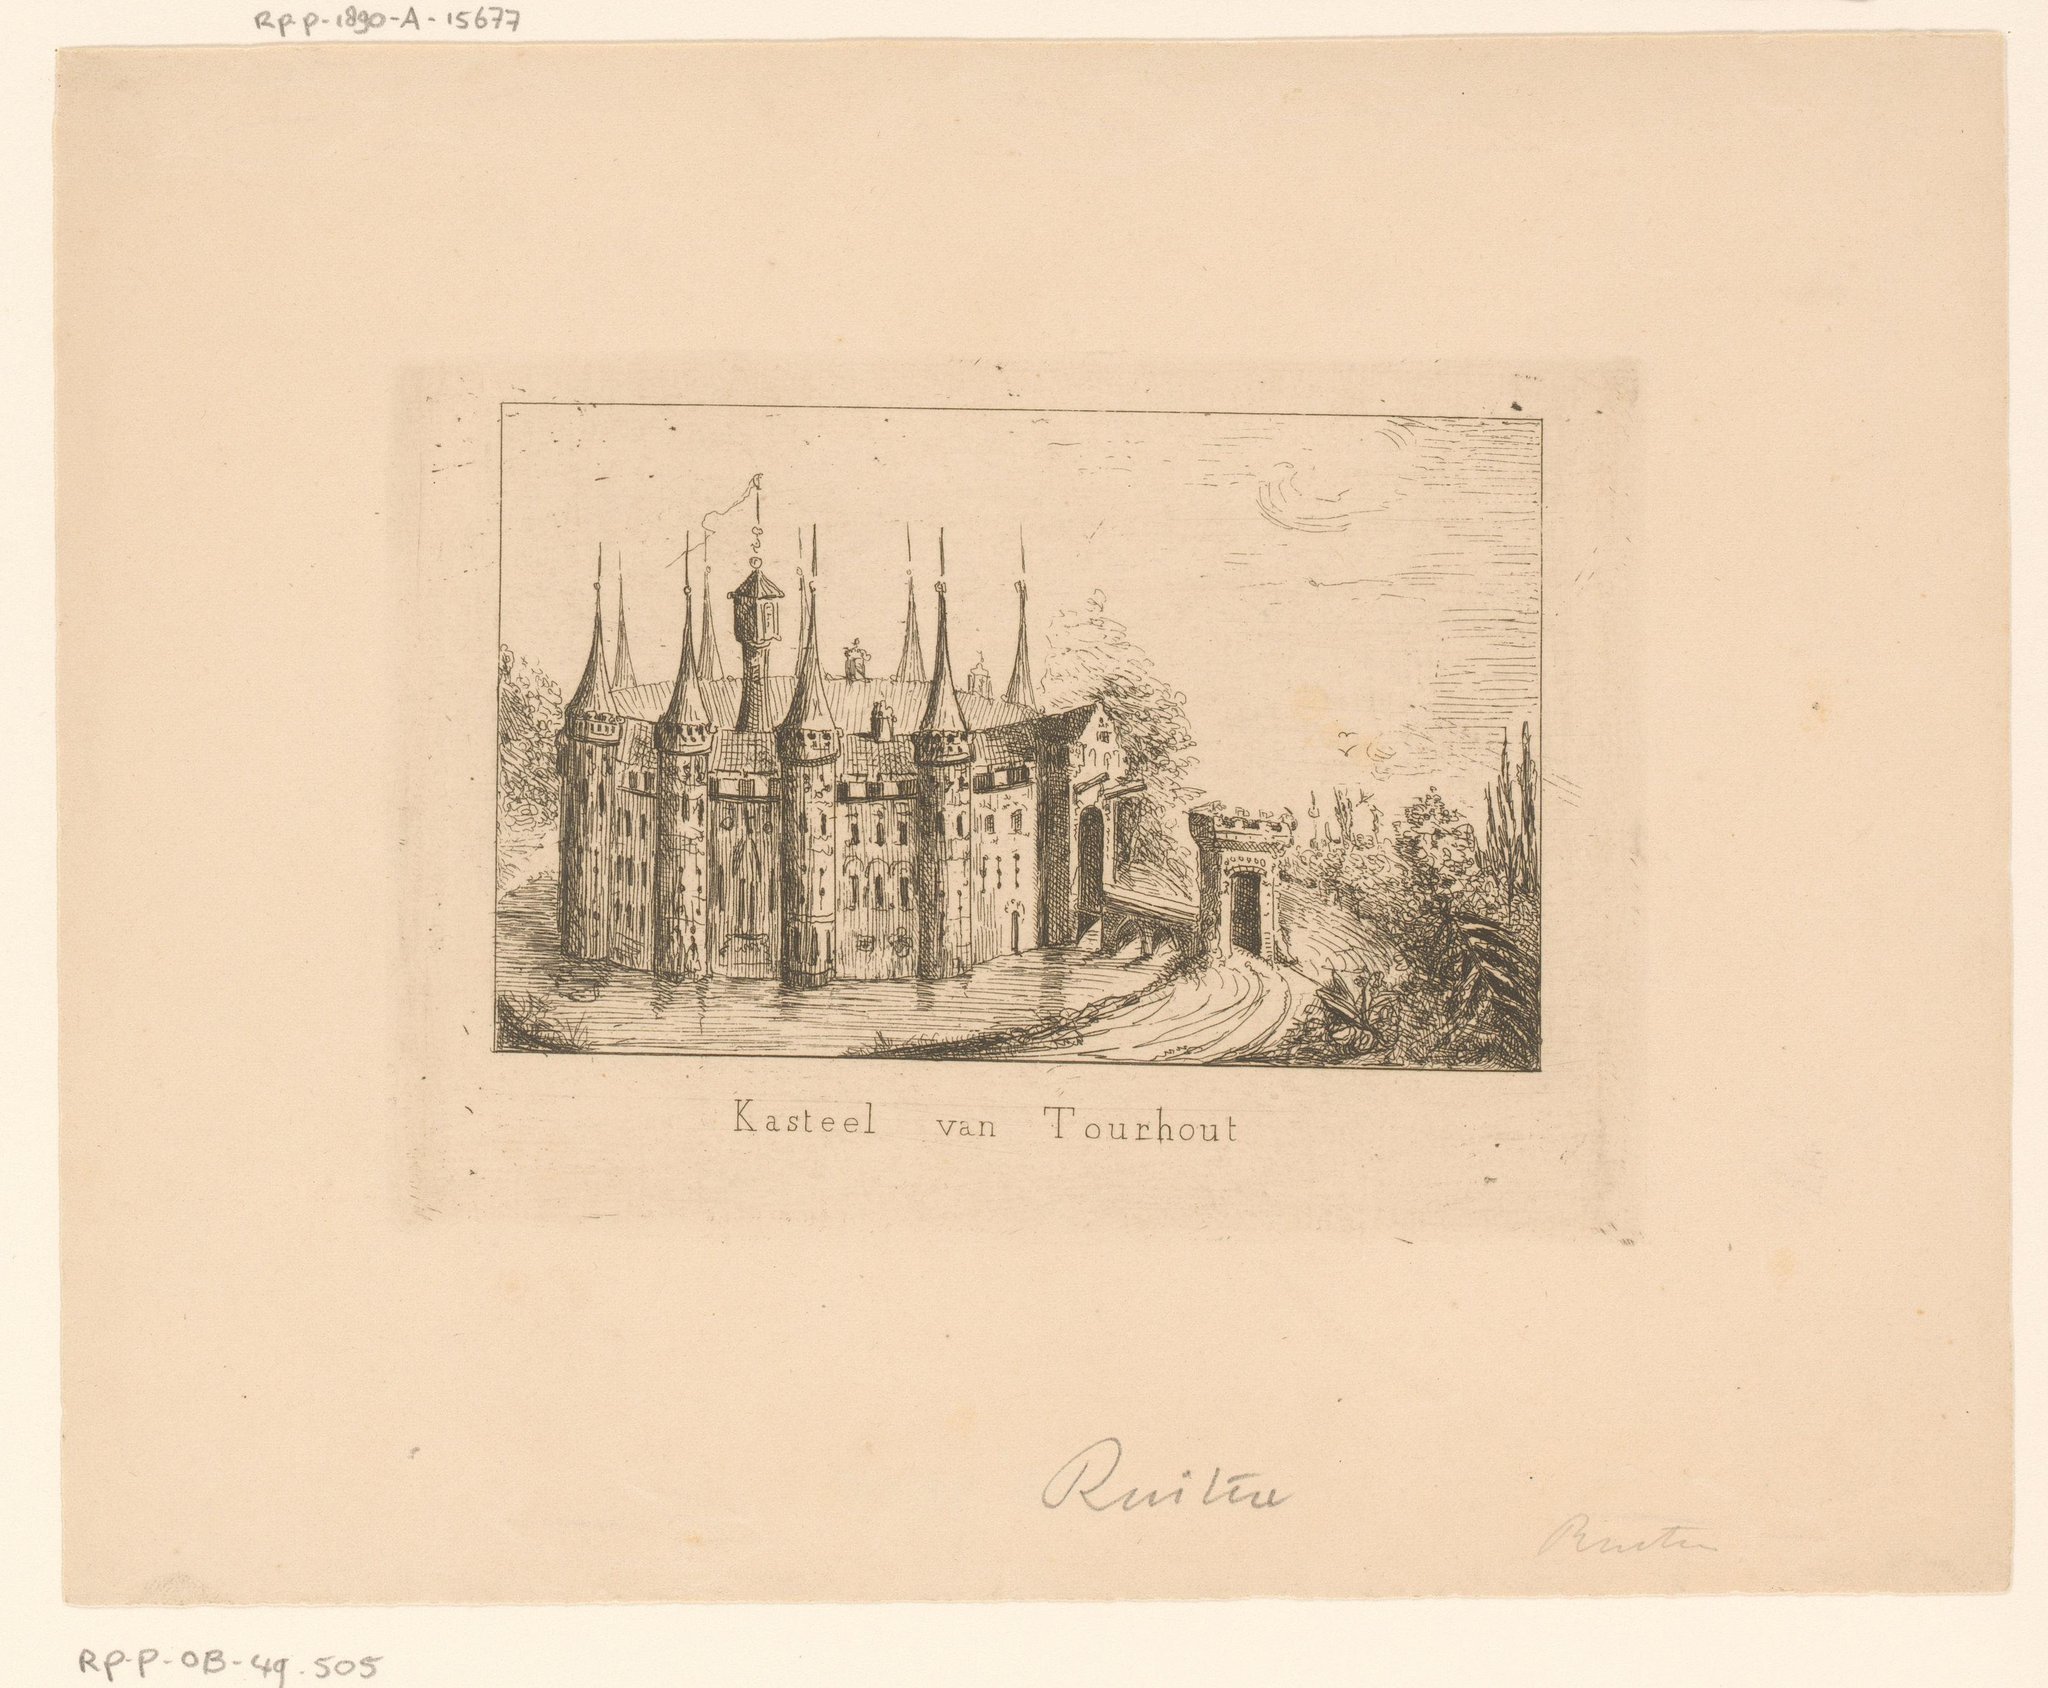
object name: print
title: Kasteel van Tourhout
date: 1811-1900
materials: paper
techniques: etching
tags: castle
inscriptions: collector's mark: Lugt 2228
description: Prent is zeer vergelijkbaar met RP-P-1913-1969, mogelijk gaat het om dezelfde vervaardiger.